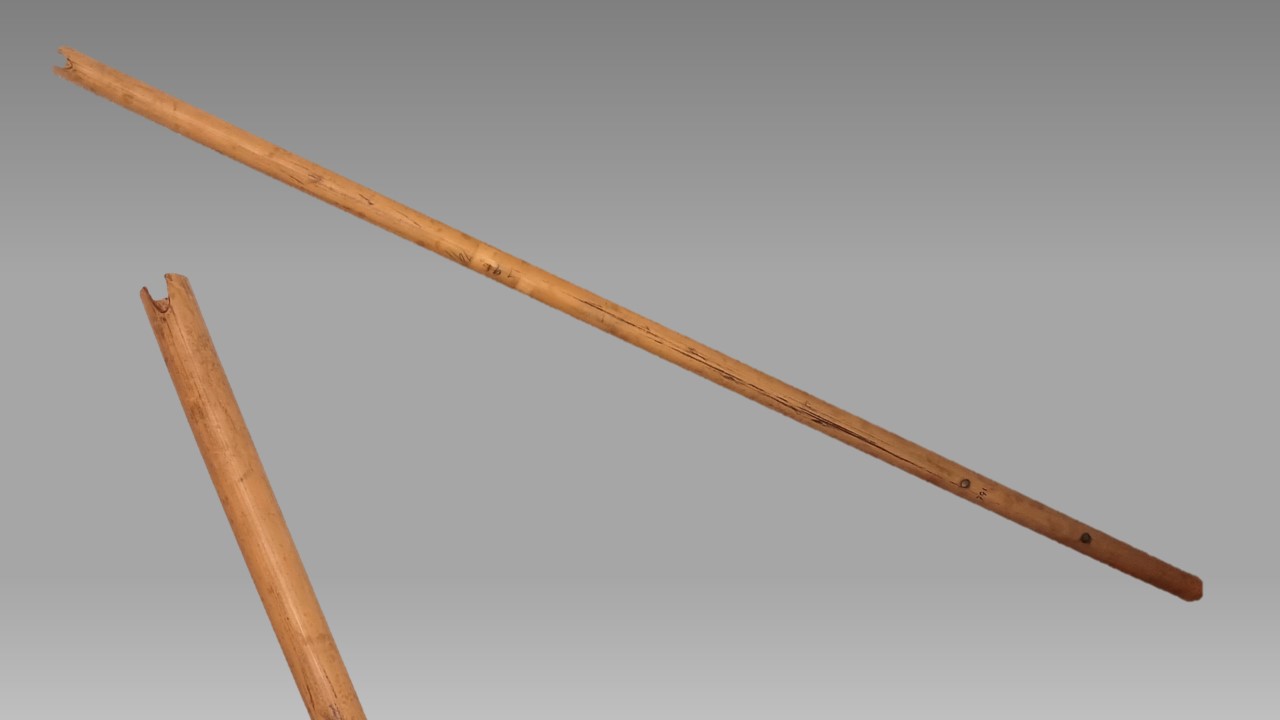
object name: gore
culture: melanesian, aoba island or vanuatuan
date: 1867-1900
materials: bamboo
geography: vanuatu